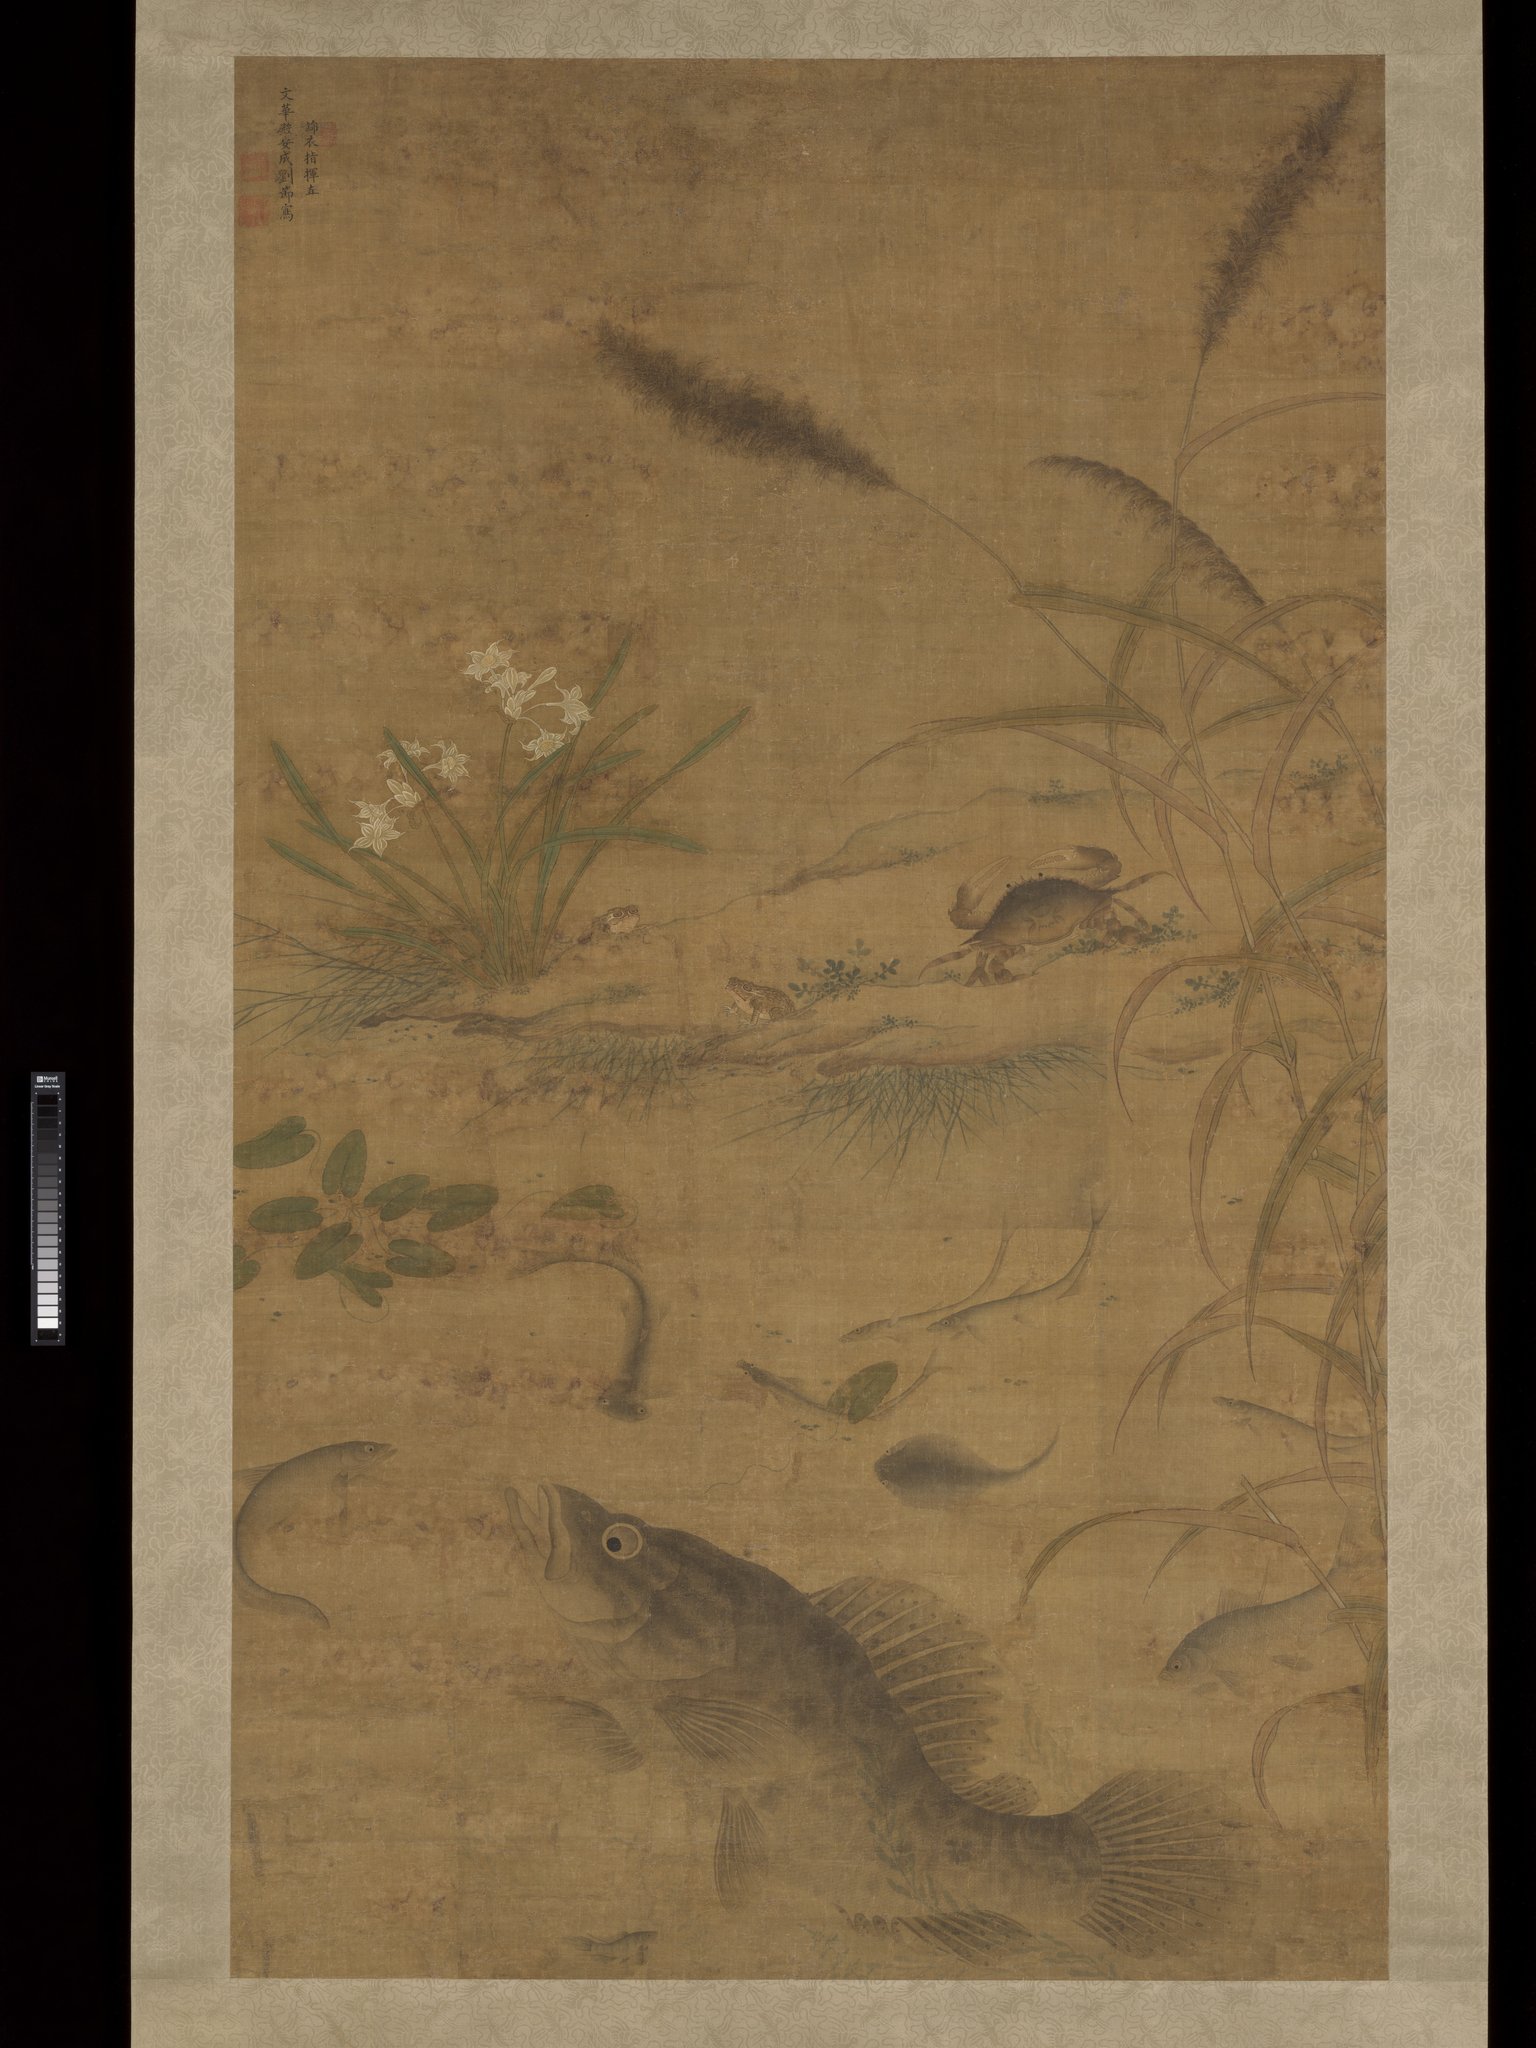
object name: hanging scroll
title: Flowers, fish, and crabs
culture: chinese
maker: liu jie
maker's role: artist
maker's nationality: chinese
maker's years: 1534-1566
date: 1534-1566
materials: ink, silk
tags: crabs,fish,flowers